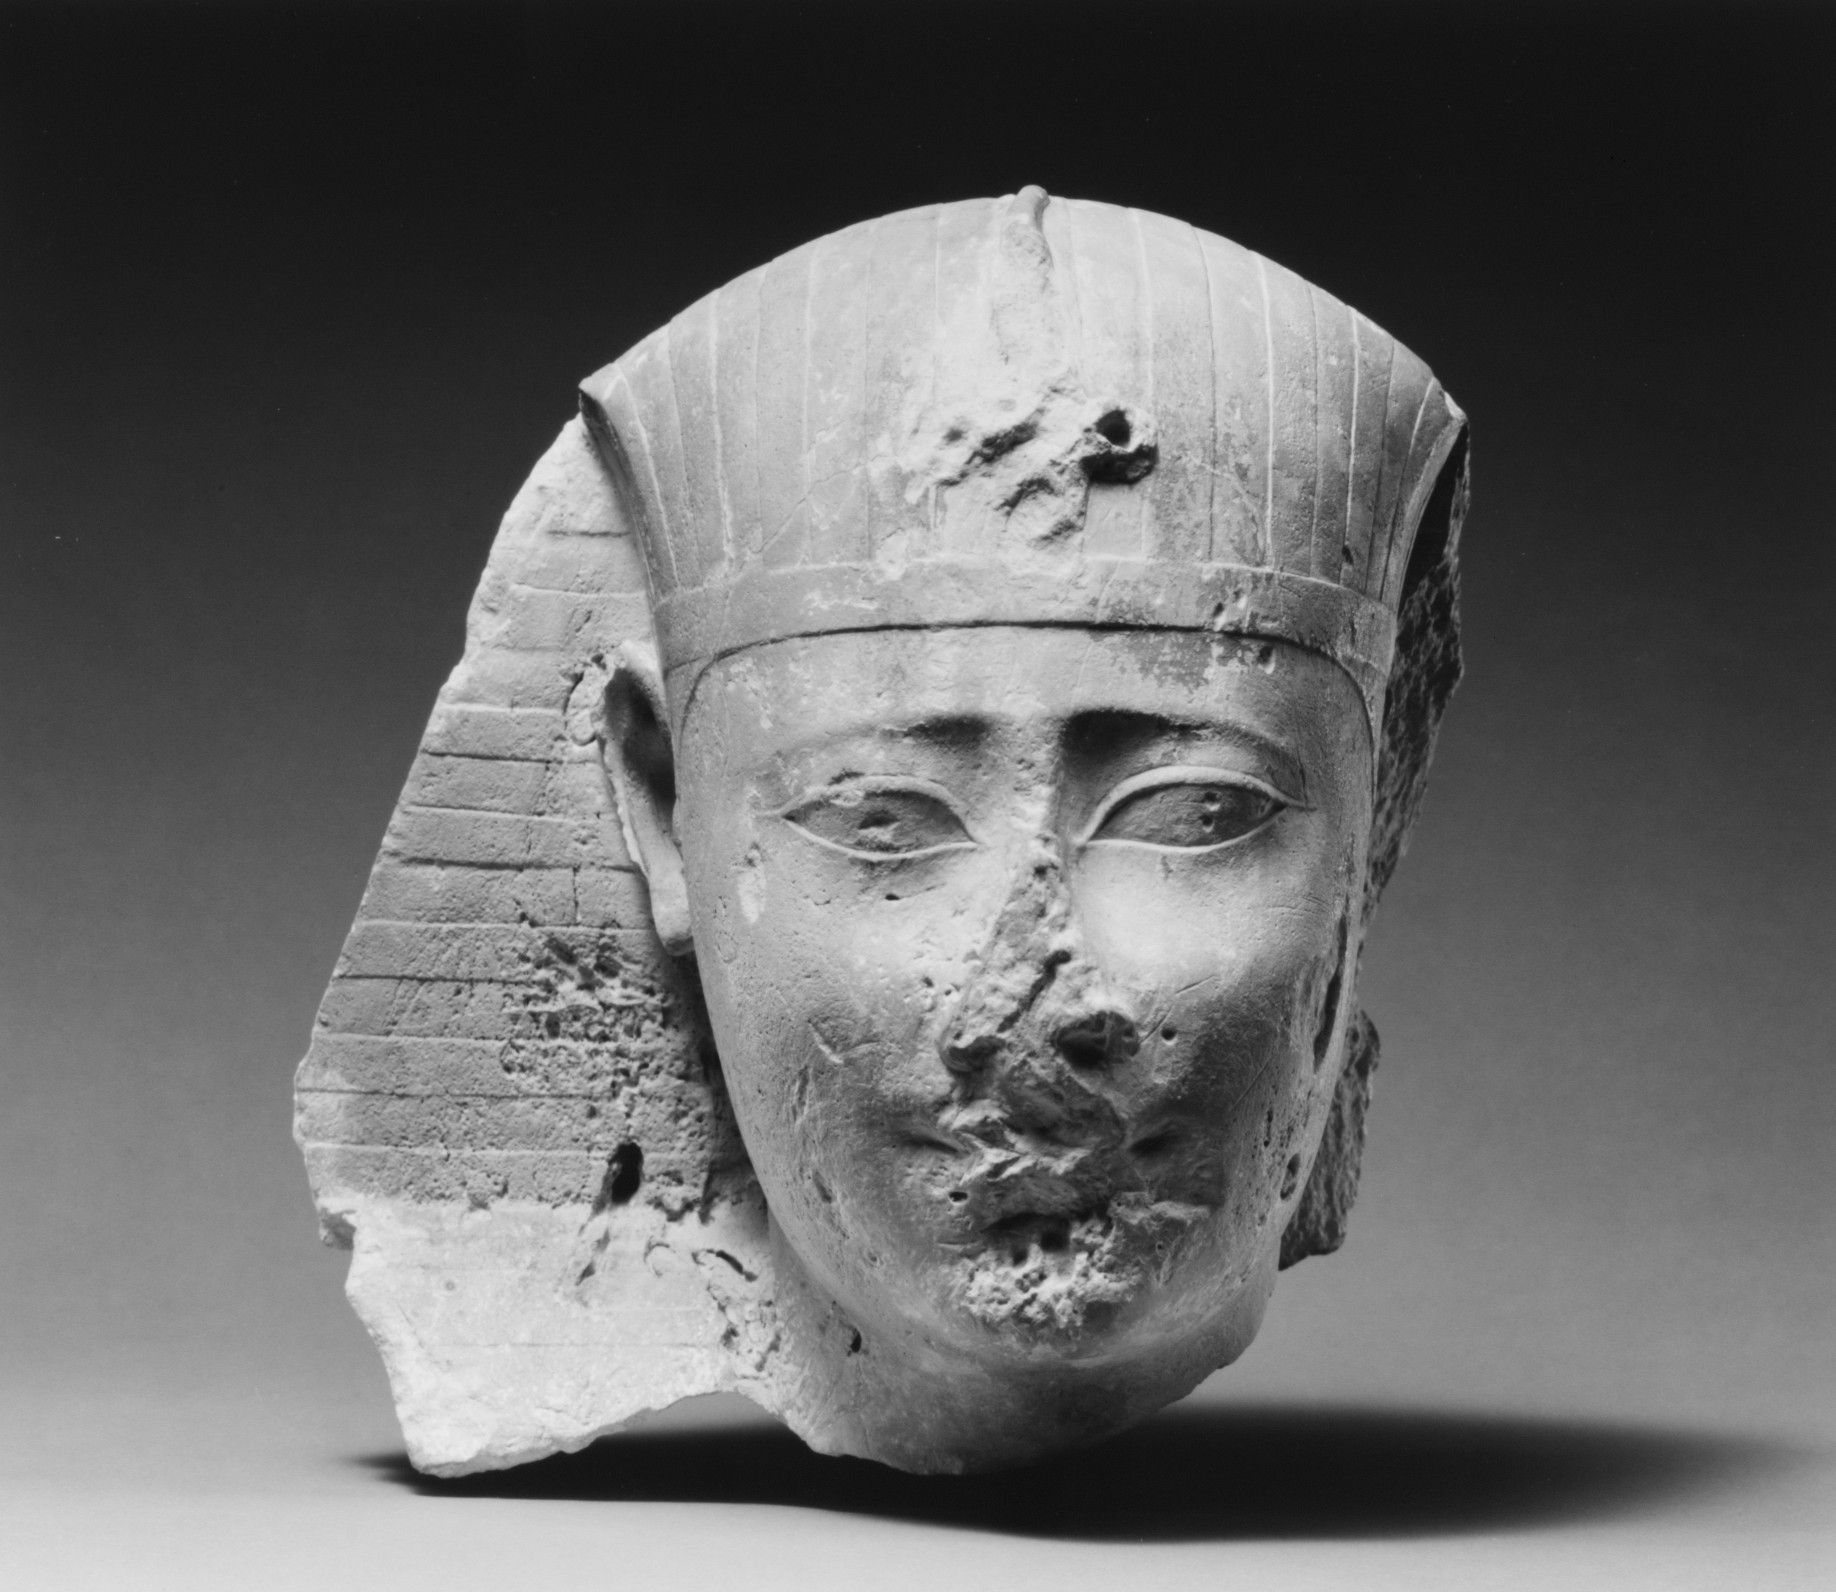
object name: head, royal, early ptolemy, from a sphinx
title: Head of an early Ptolemy, possibly from a sphinx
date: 400-268 BCE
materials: limestone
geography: egypt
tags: sphinx